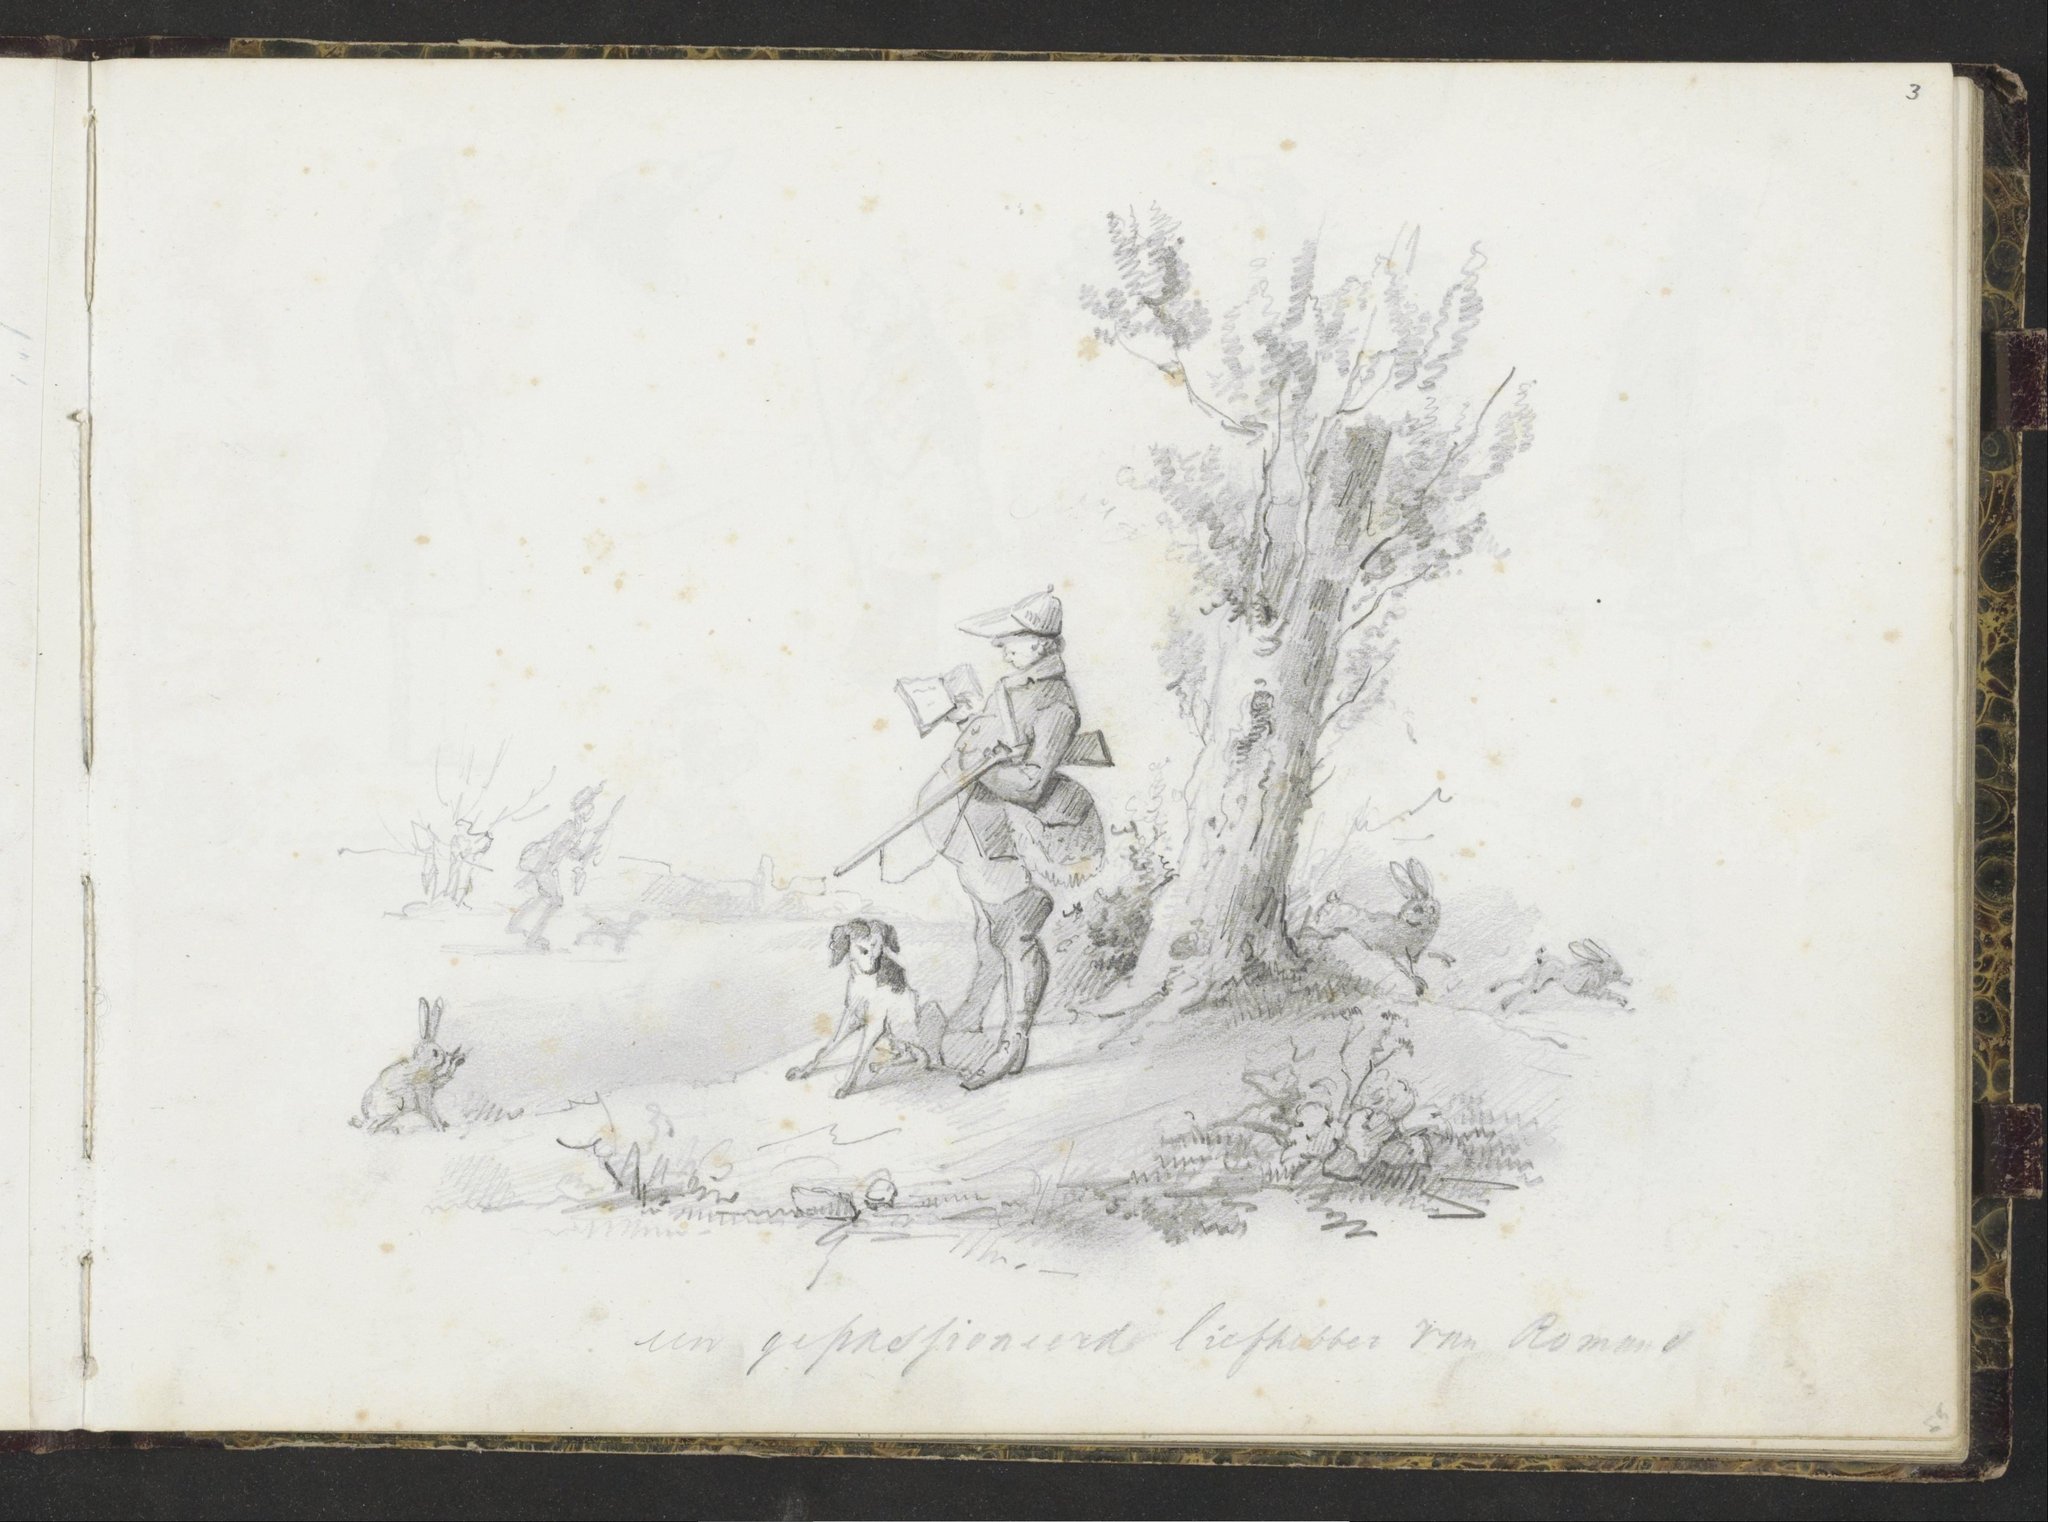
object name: sketchbook leaf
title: Jager die een roman leest bij een boom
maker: lambertus lingeman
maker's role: draughtsman, painter, print maker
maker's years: 1829-1894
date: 1839-1894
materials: paper, pencil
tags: reading, hunter, hunting accoutrement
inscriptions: annotation: ‘een gepassioneerde liefhebber van Romans’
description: Een jager staat met zijn geweer onder de arm een roman te lezen in een landschap. Aan zijn voeten zit een hond en om hen heen zitten en springen hazen. Op de achtergrond een jager met hond. Blad 3 recto uit een schetsboek met 51 bladen.